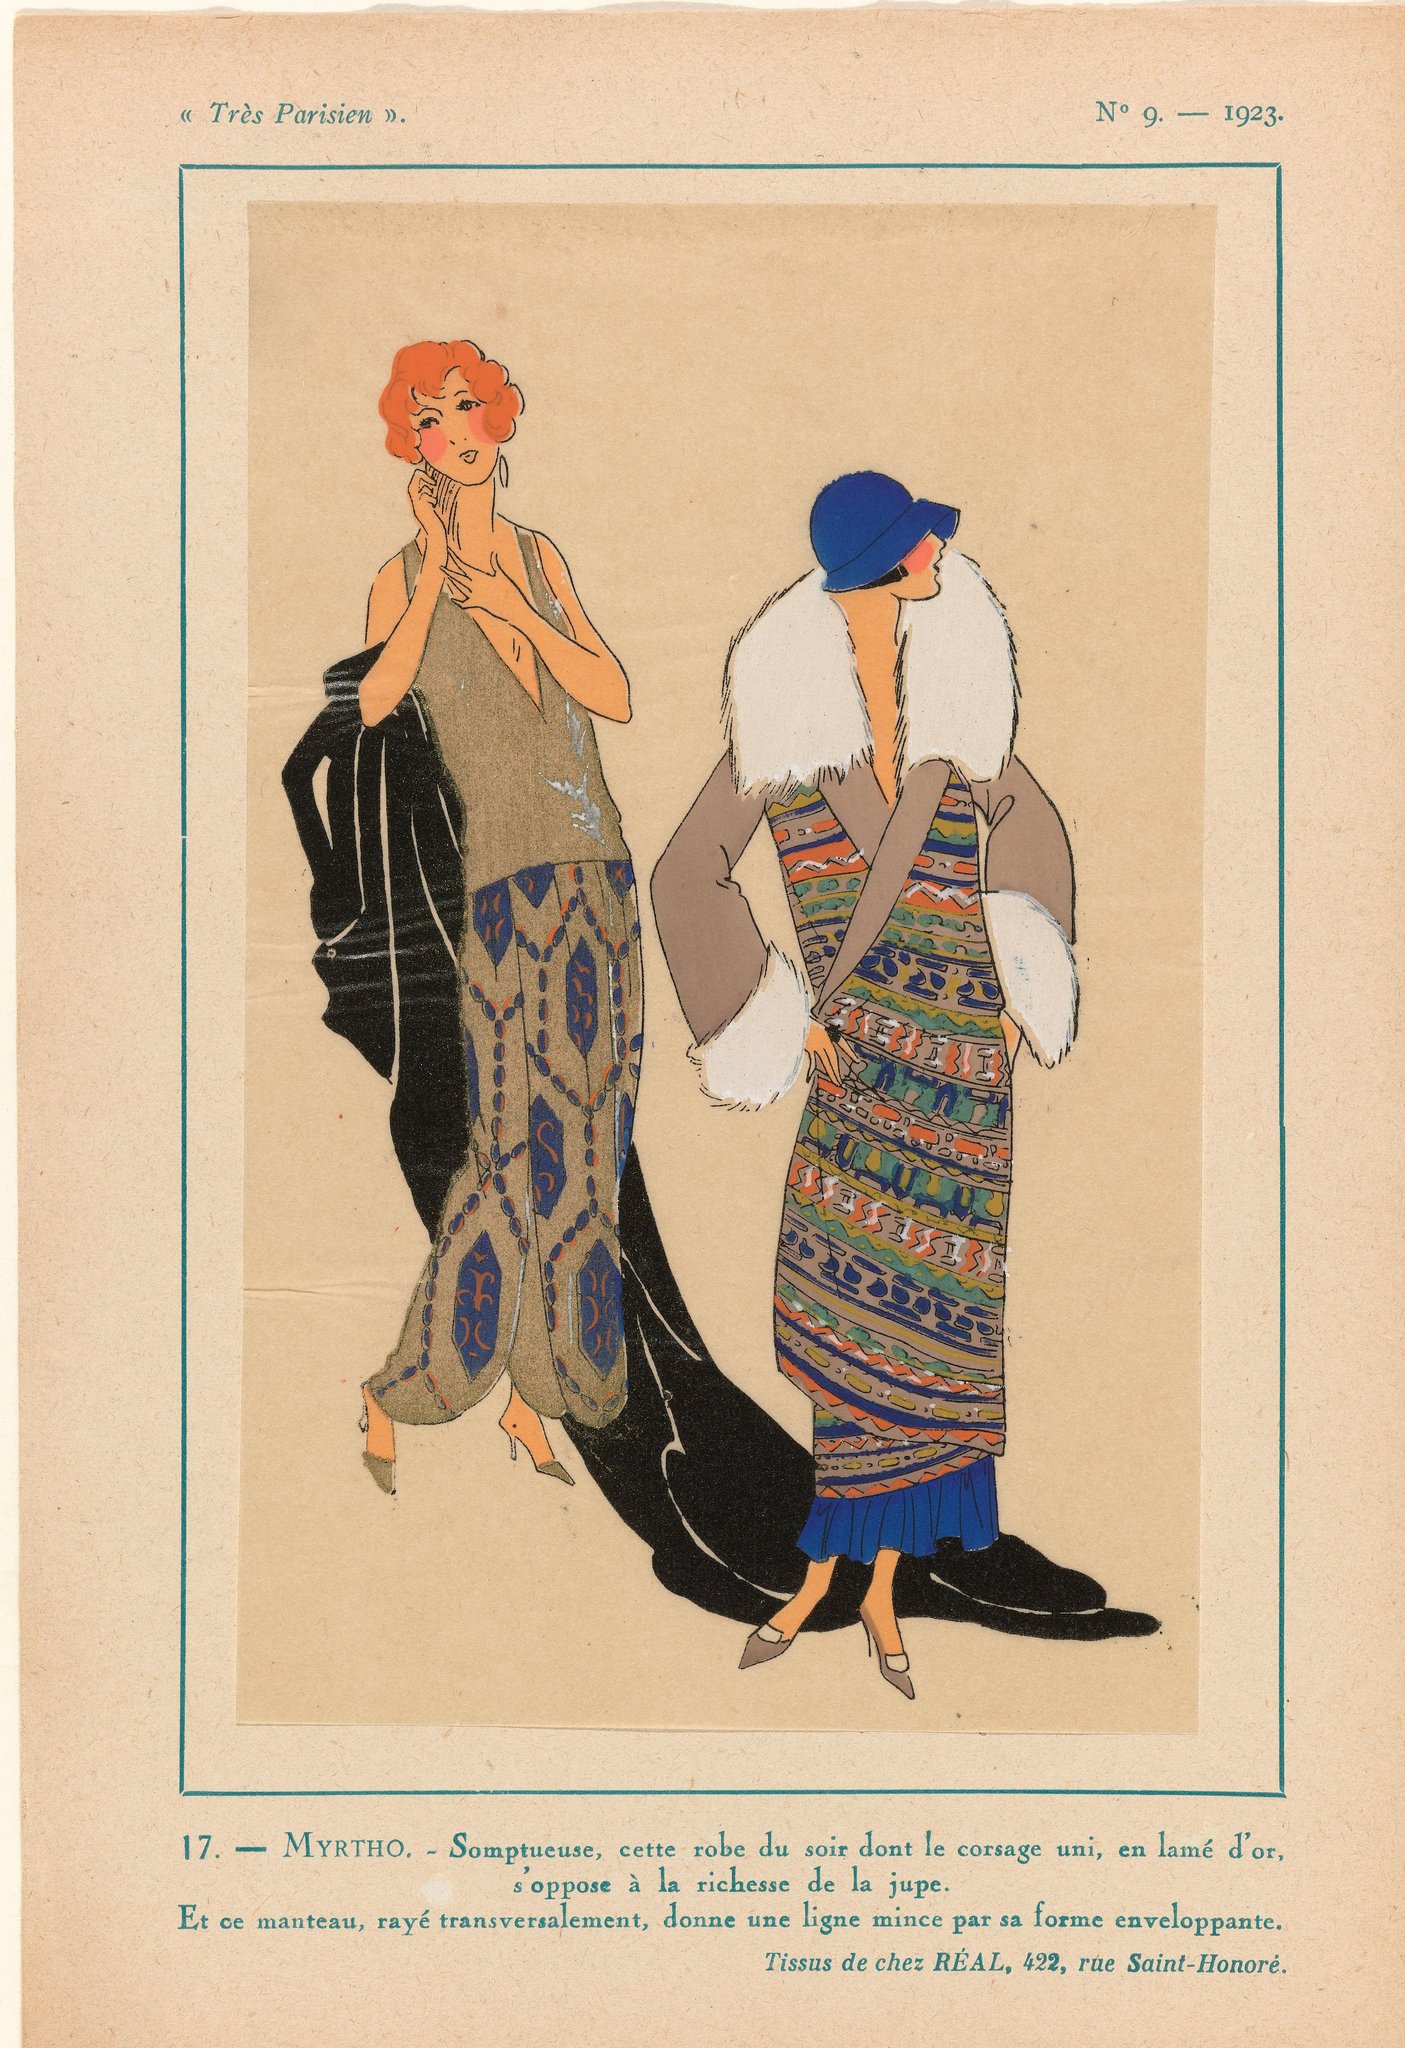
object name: fashion print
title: Très Parisien, 1923, No 9: 17. - MYRTHO. - Somptueuse, cette robe du soir...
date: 1923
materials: paper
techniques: hand coloring, letterpress printing, lithography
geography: paris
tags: dress, gown: evening dress (+ women's clothes), clothing for the upper part of the body (shawl) (+ women's clothes), border, ribbon, braid (+ fur used for clothes), coat (+ women's clothes), fashion plates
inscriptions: caption: ‘17. - MYRTHO. - Somptueuse, cette robe du soir dont le corsage uni, en lamé d'or, s'opose à la richesse de la jupe. Et ce manteau, rayé transversalement, donne une ligne mince par sa forme enveloppante. / Tissus de chez RÉAL, 422, rue Saint-Honoré.’, title: ‘Très Parisien / No 9. - 1923’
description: Avondjurk met een effen lijfje van goudlamé en een rijkelijk versierde rok. Mantel met dwarse strepen, kraag en manchetten van bont. Stoffen van Réal. Accessoires: cloche (pothoed), sjaal(?), pumps.Prent uit het modetijdschrift Très Parisien (1920-1936).